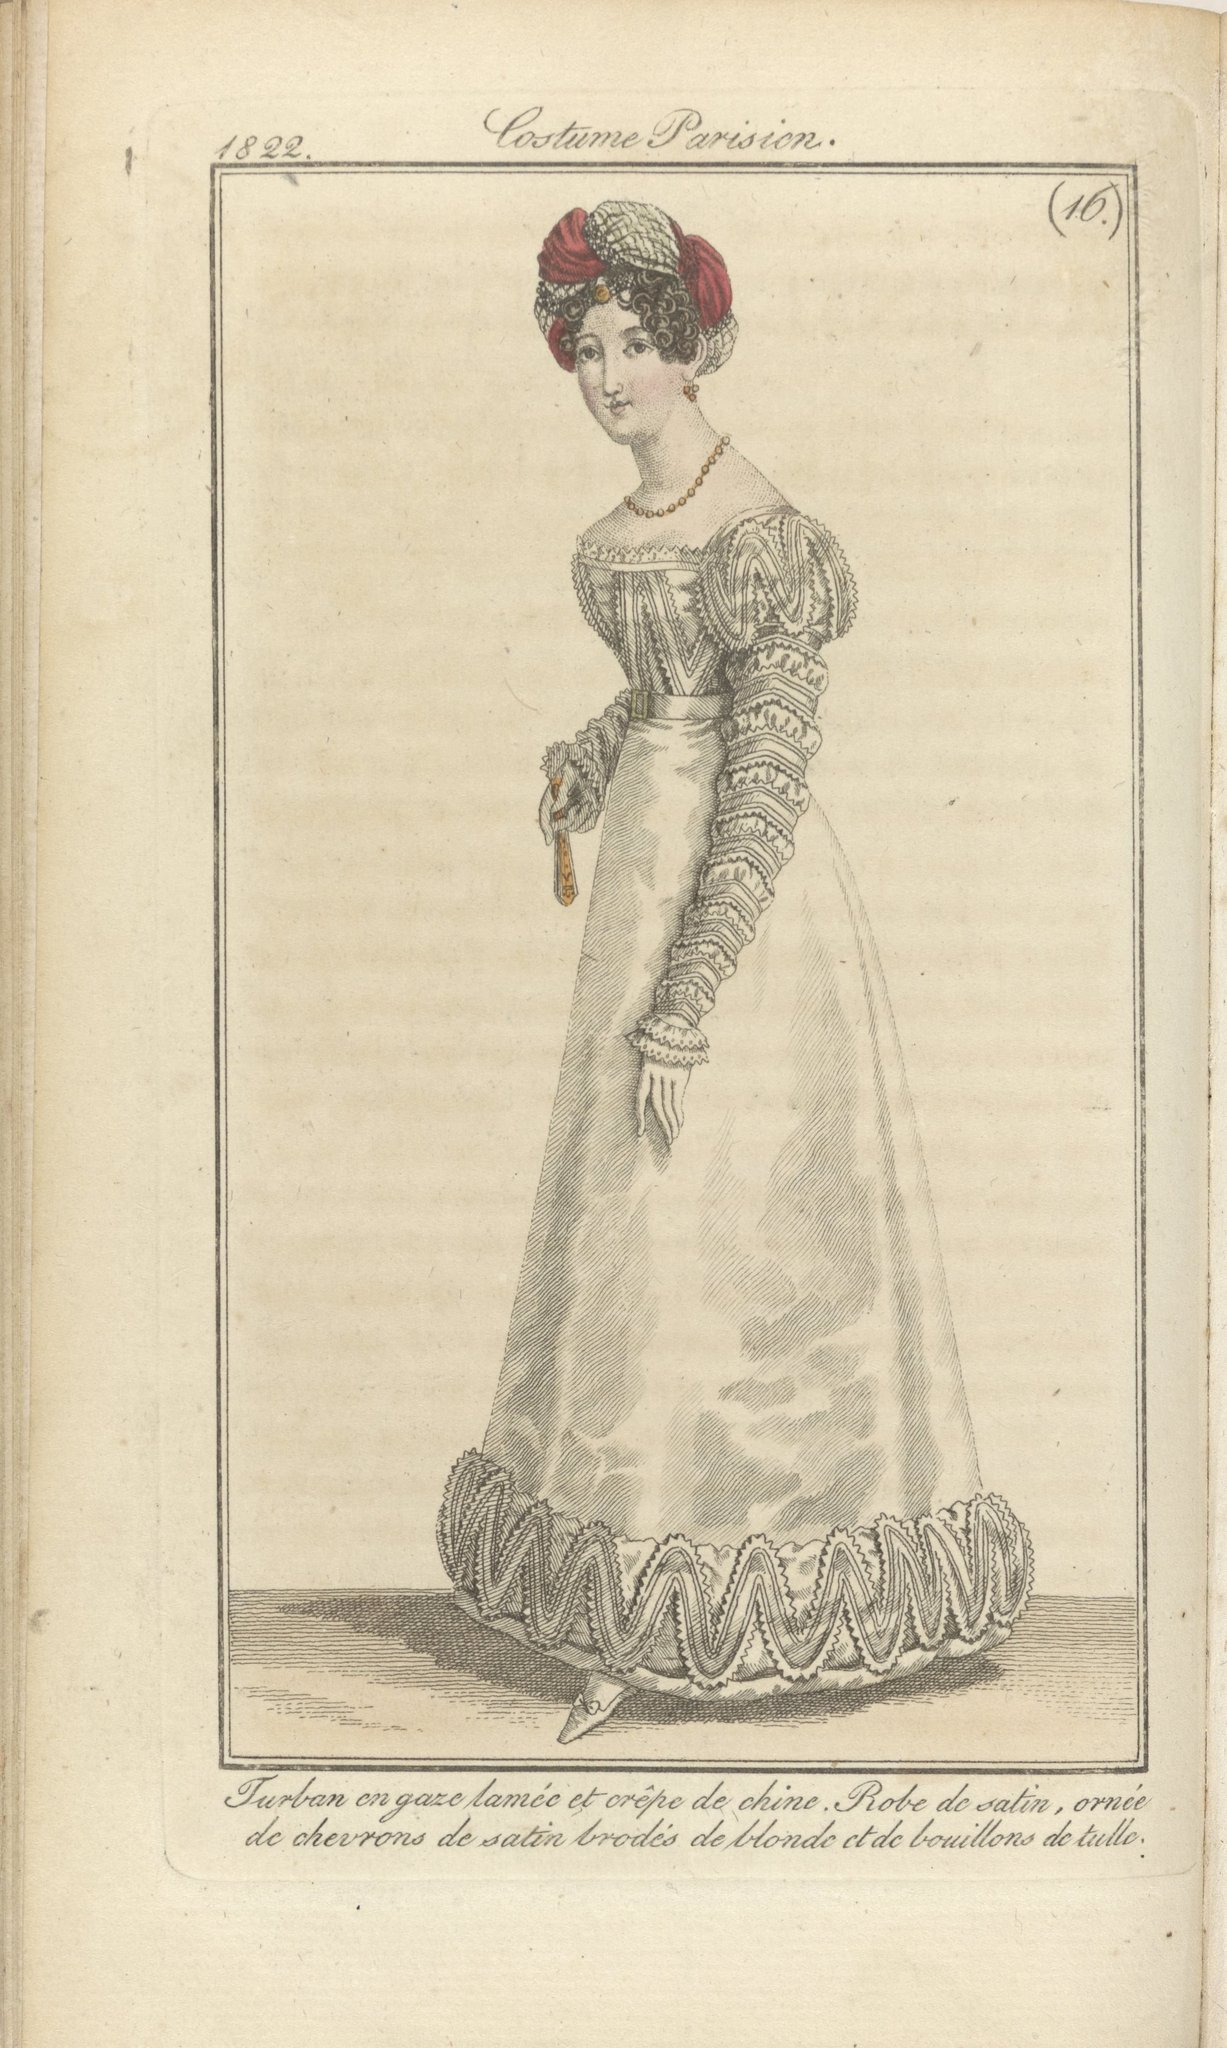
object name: fashion print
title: Journal des Dames et des Modes, editie Frankfurt 14 Avril 1822, Costumes Parisiens (16)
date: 1822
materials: paper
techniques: engraving, hand coloring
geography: frankfurt am main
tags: head-gear: turban (+ women's clothes), lace (+ women's clothes), fashion plates, gloves, mittens, etc. (+ women's clothes), dress, gown (+ women's clothes), fan (+ women's clothes), necklace (+ women's clothes)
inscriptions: title: ‘Costume Parisien (16.)’, date: ‘1822’, caption: ‘Turban en gaze lamée et crêpe de chine. Robe de satin, ornée de chevrons de satin brodés de blonde et de bouillons de tulle.’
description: Volgens het onderschrift en de begeleidende tekst (p. 432): Tulband van 'gaze lamée' en crêpe de chine'. Japon van satijn versierd met satijnen 'chevrons' afgezet met Blonde (kloskant) en 'bouillons' van tule. De prent maakt deel uit van het modetijdschrift Journal des Dames et des Modes, uitgegeven in Frankfurt als kopie van de Franse editie van Pierre de la Mésangère, Parijs, 1797-1839. Figuur gekopieerd naar Costume Parisien 2057. Volgens het onderschrift aldaar is de tulband een ontwerp van M. Du Plessis en de japon een creatie van Madame Bouhot.